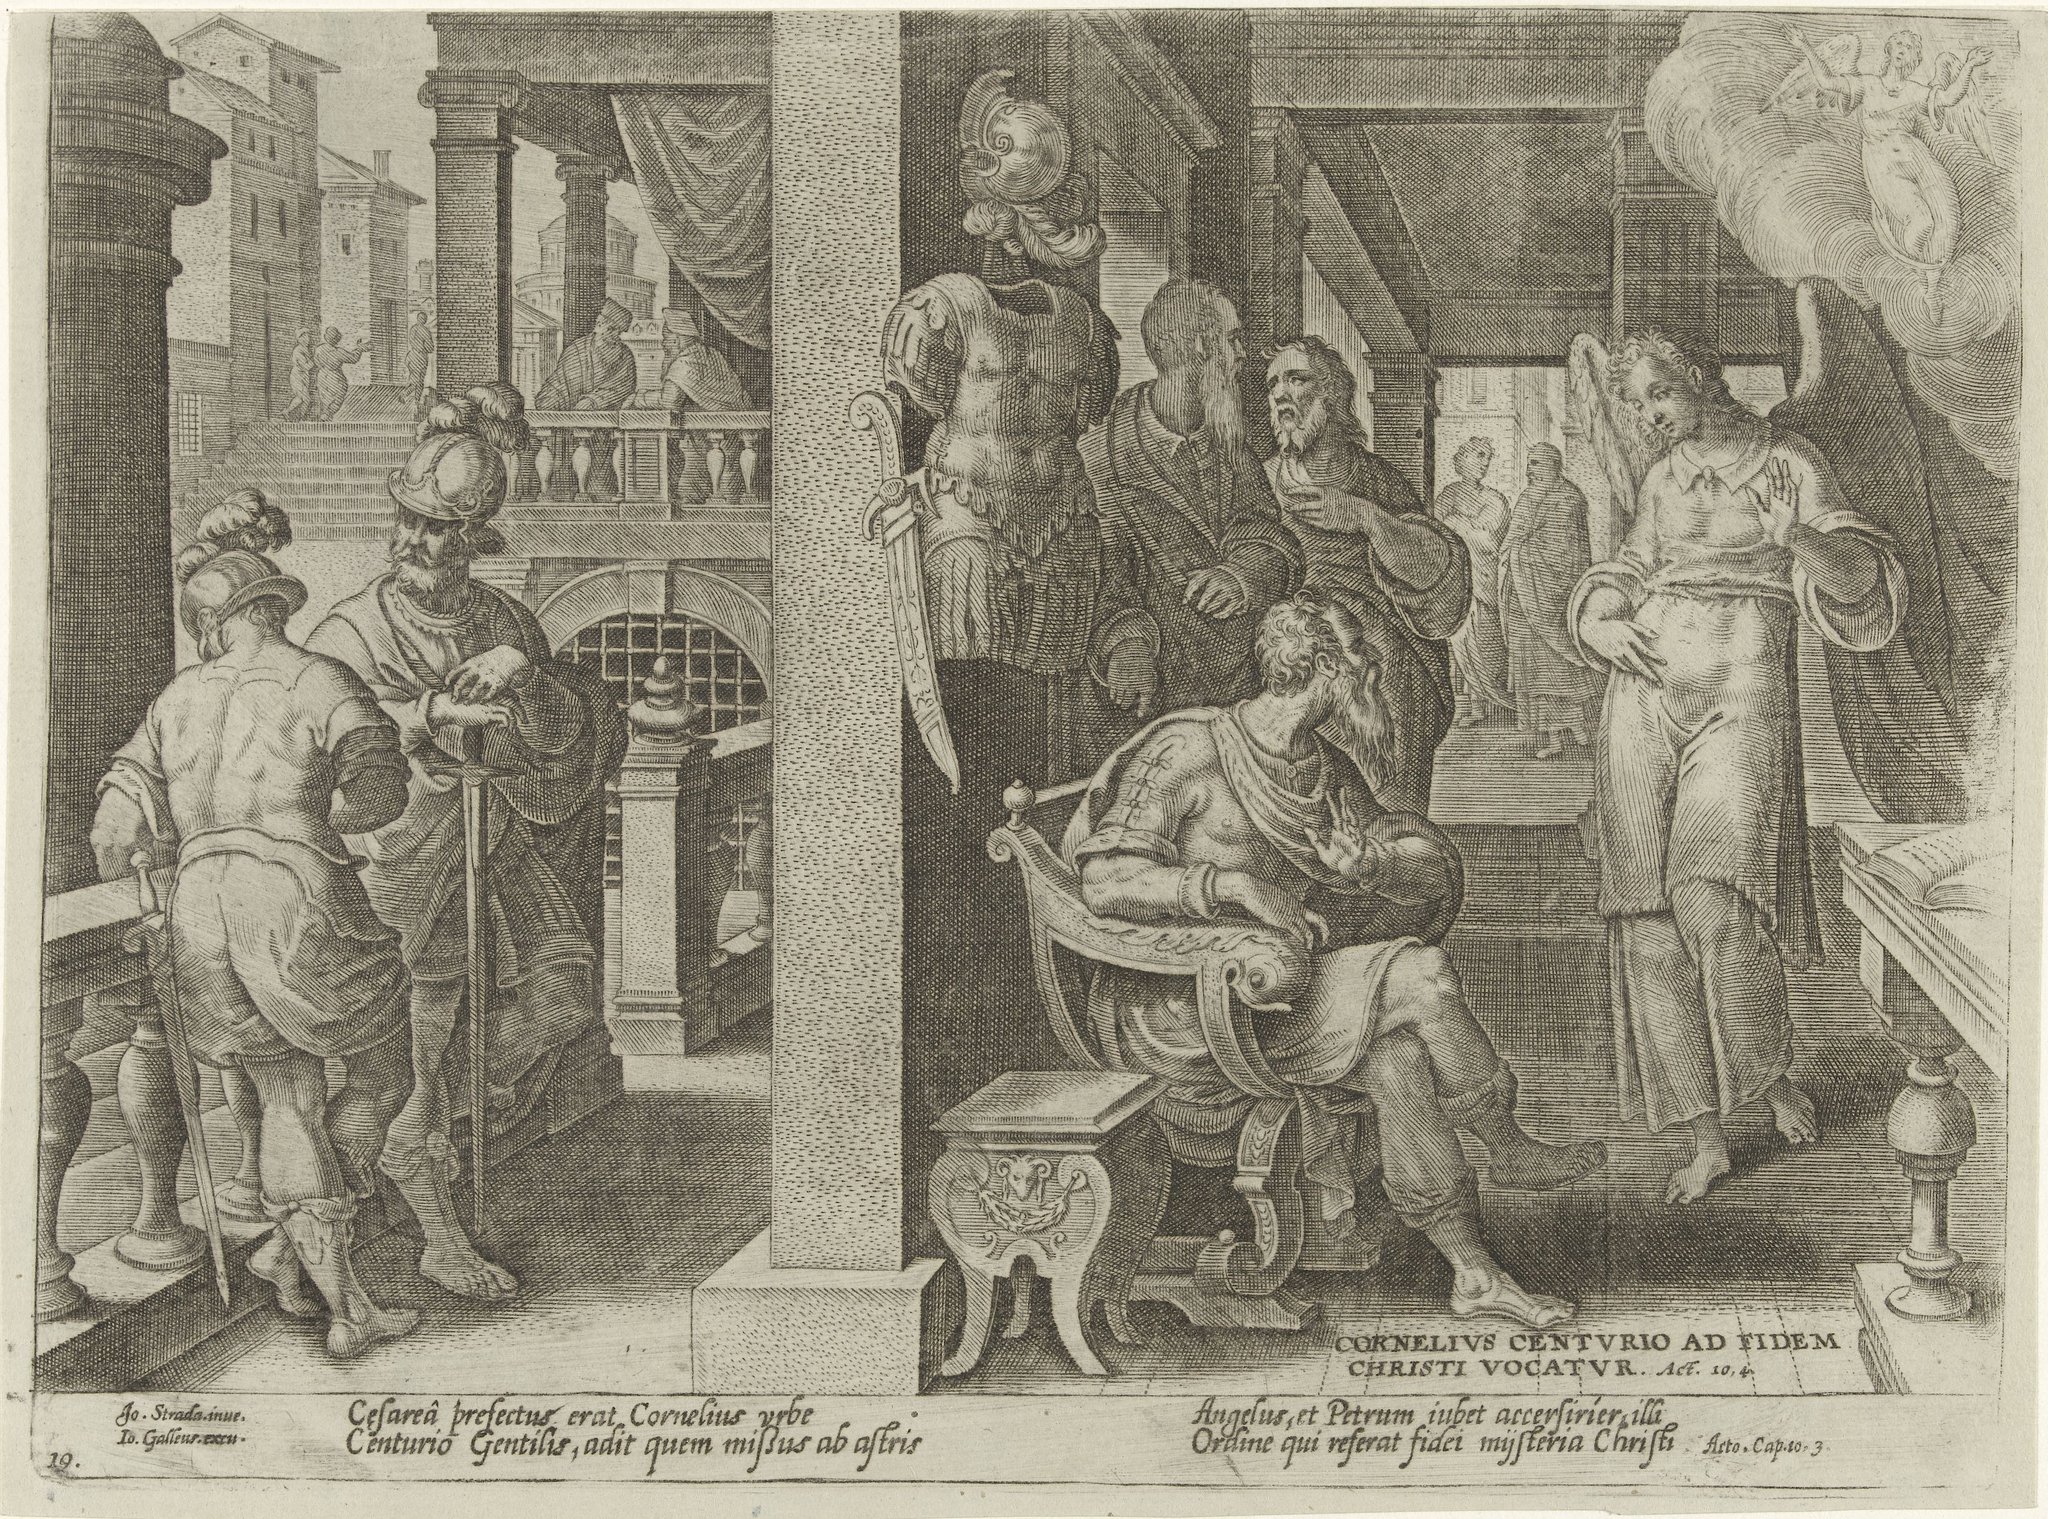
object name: print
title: Visioen van Cornelius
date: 1582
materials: paper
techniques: engraving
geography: florence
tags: cornelius sends two servants and a soldier to peter in joppa, cornelius the centurion and the angel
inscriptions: collector's mark: Lugt 2228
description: Een engel verschijnt voor Cornelius in een visioen. Hij beveelt hem de apostel Petrus op te zoeken. Twee soldaten worden eropuit gestuurd om Petrus te halen. De prent heeft een Latijns onderschrift en maakt deel uit van een 34-delige serie met als onderwerp de Handelingen van de apostelen.